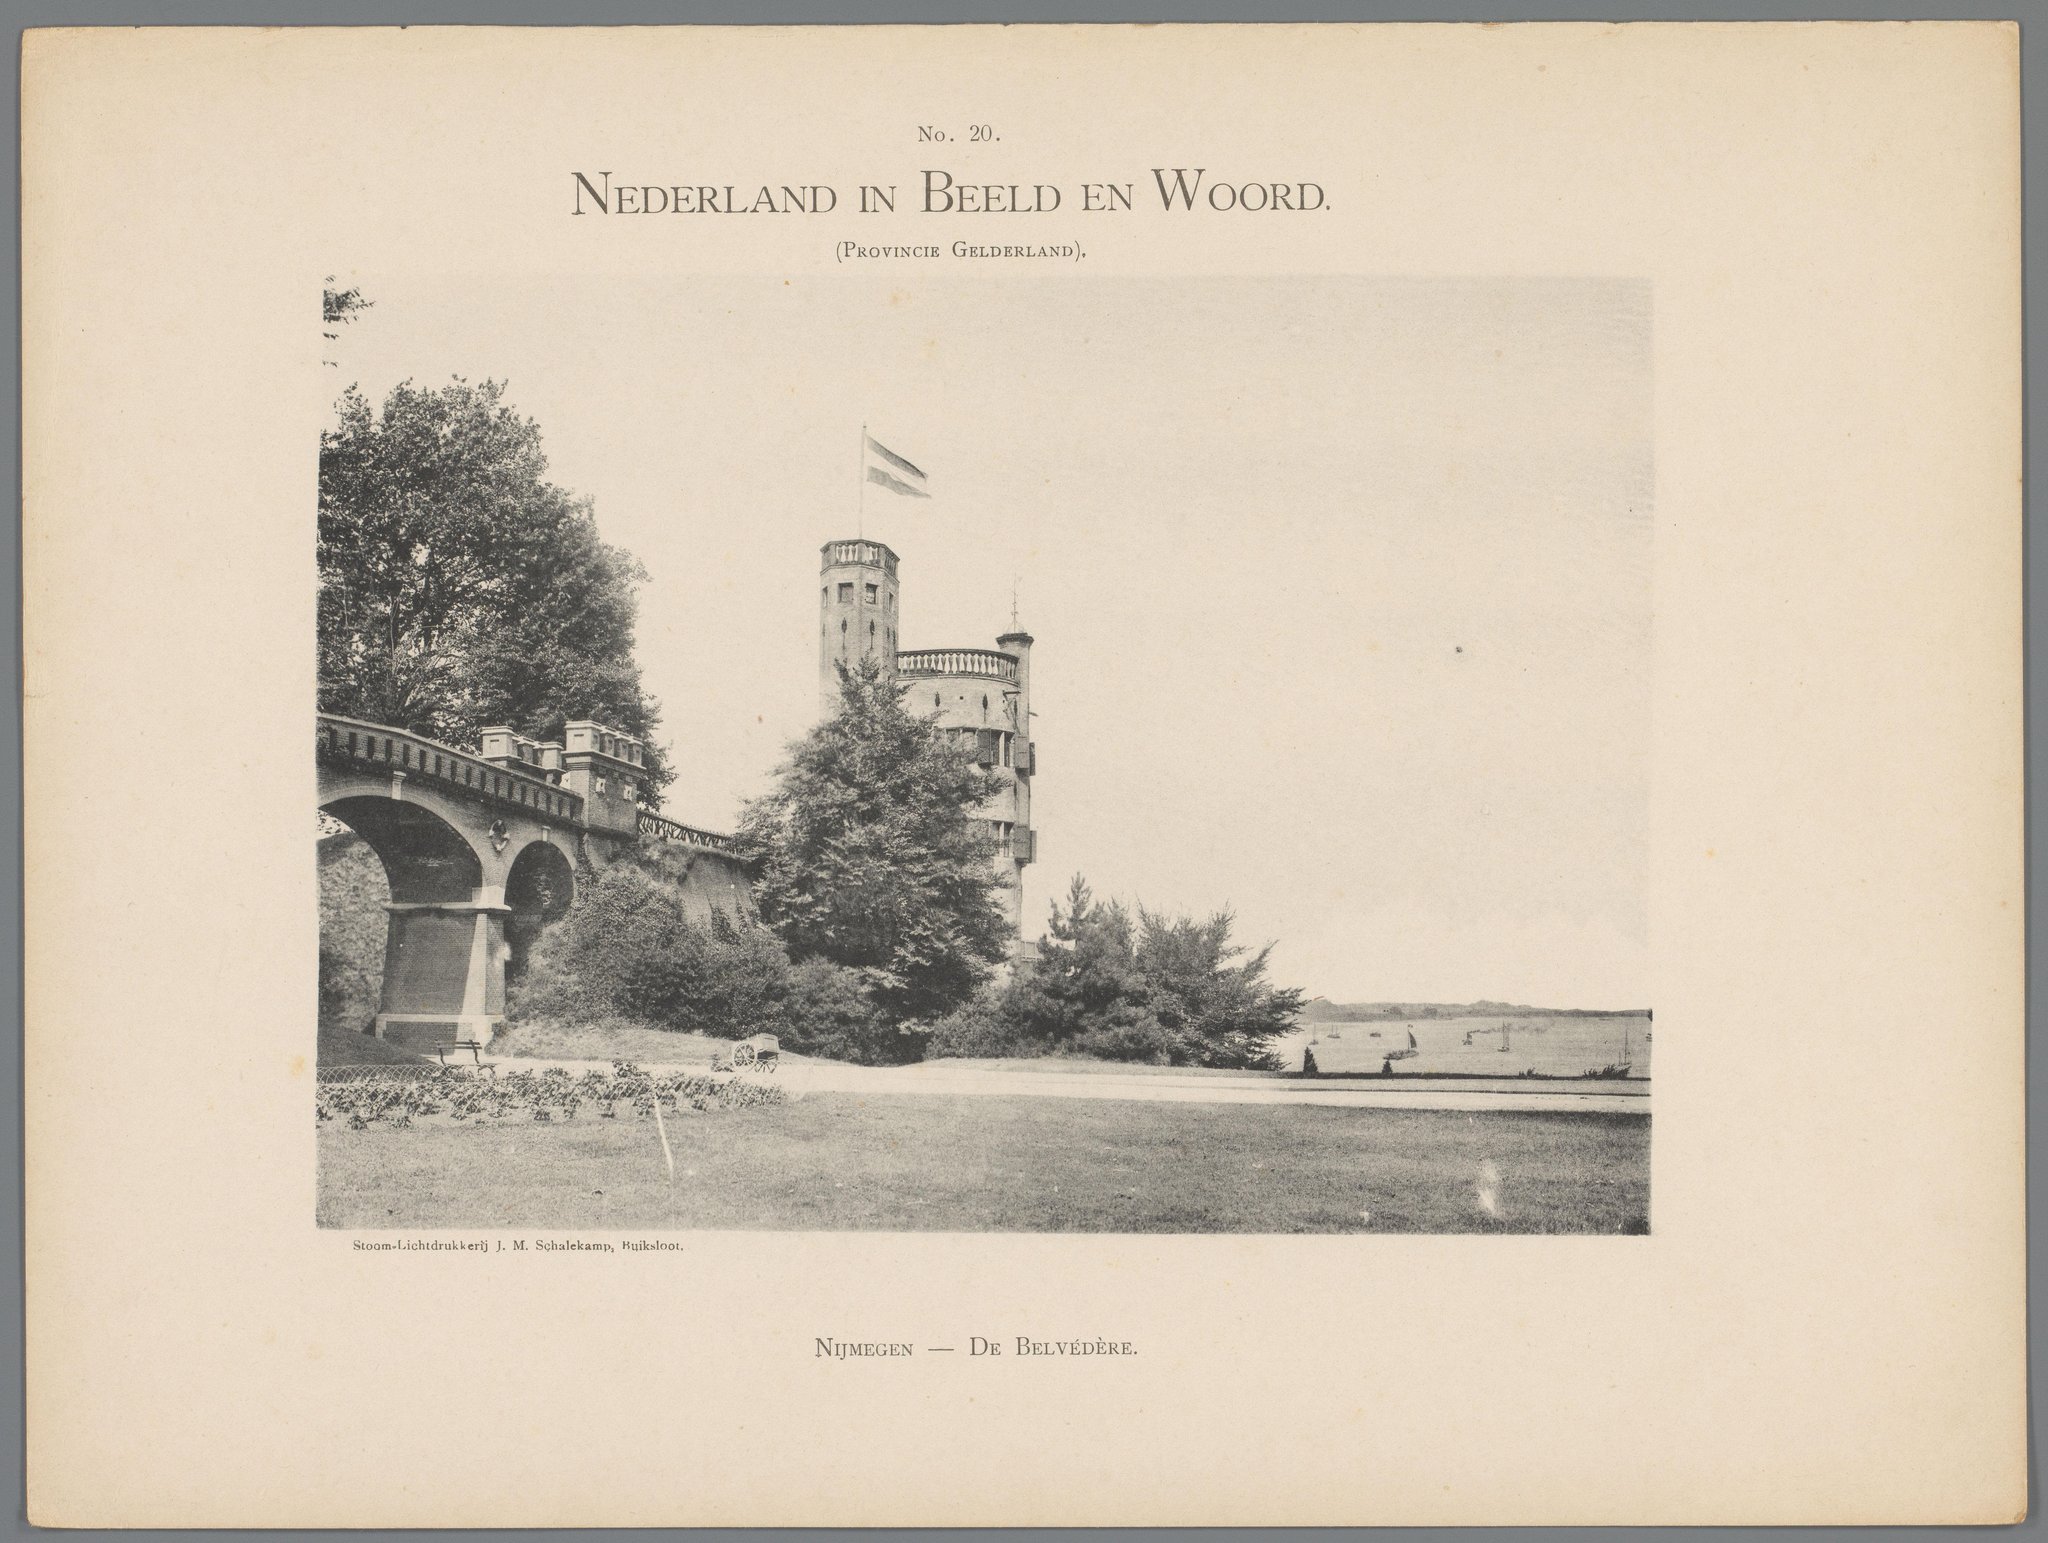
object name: photomechanical print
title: Gezicht op de Belvédère met rechts de Waal, Nijmegen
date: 1890-1895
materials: cardboard, paper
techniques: photograph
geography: buiksloot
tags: tower, clock tower ~ monumental adornment, river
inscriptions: number: ‘No. 20.’